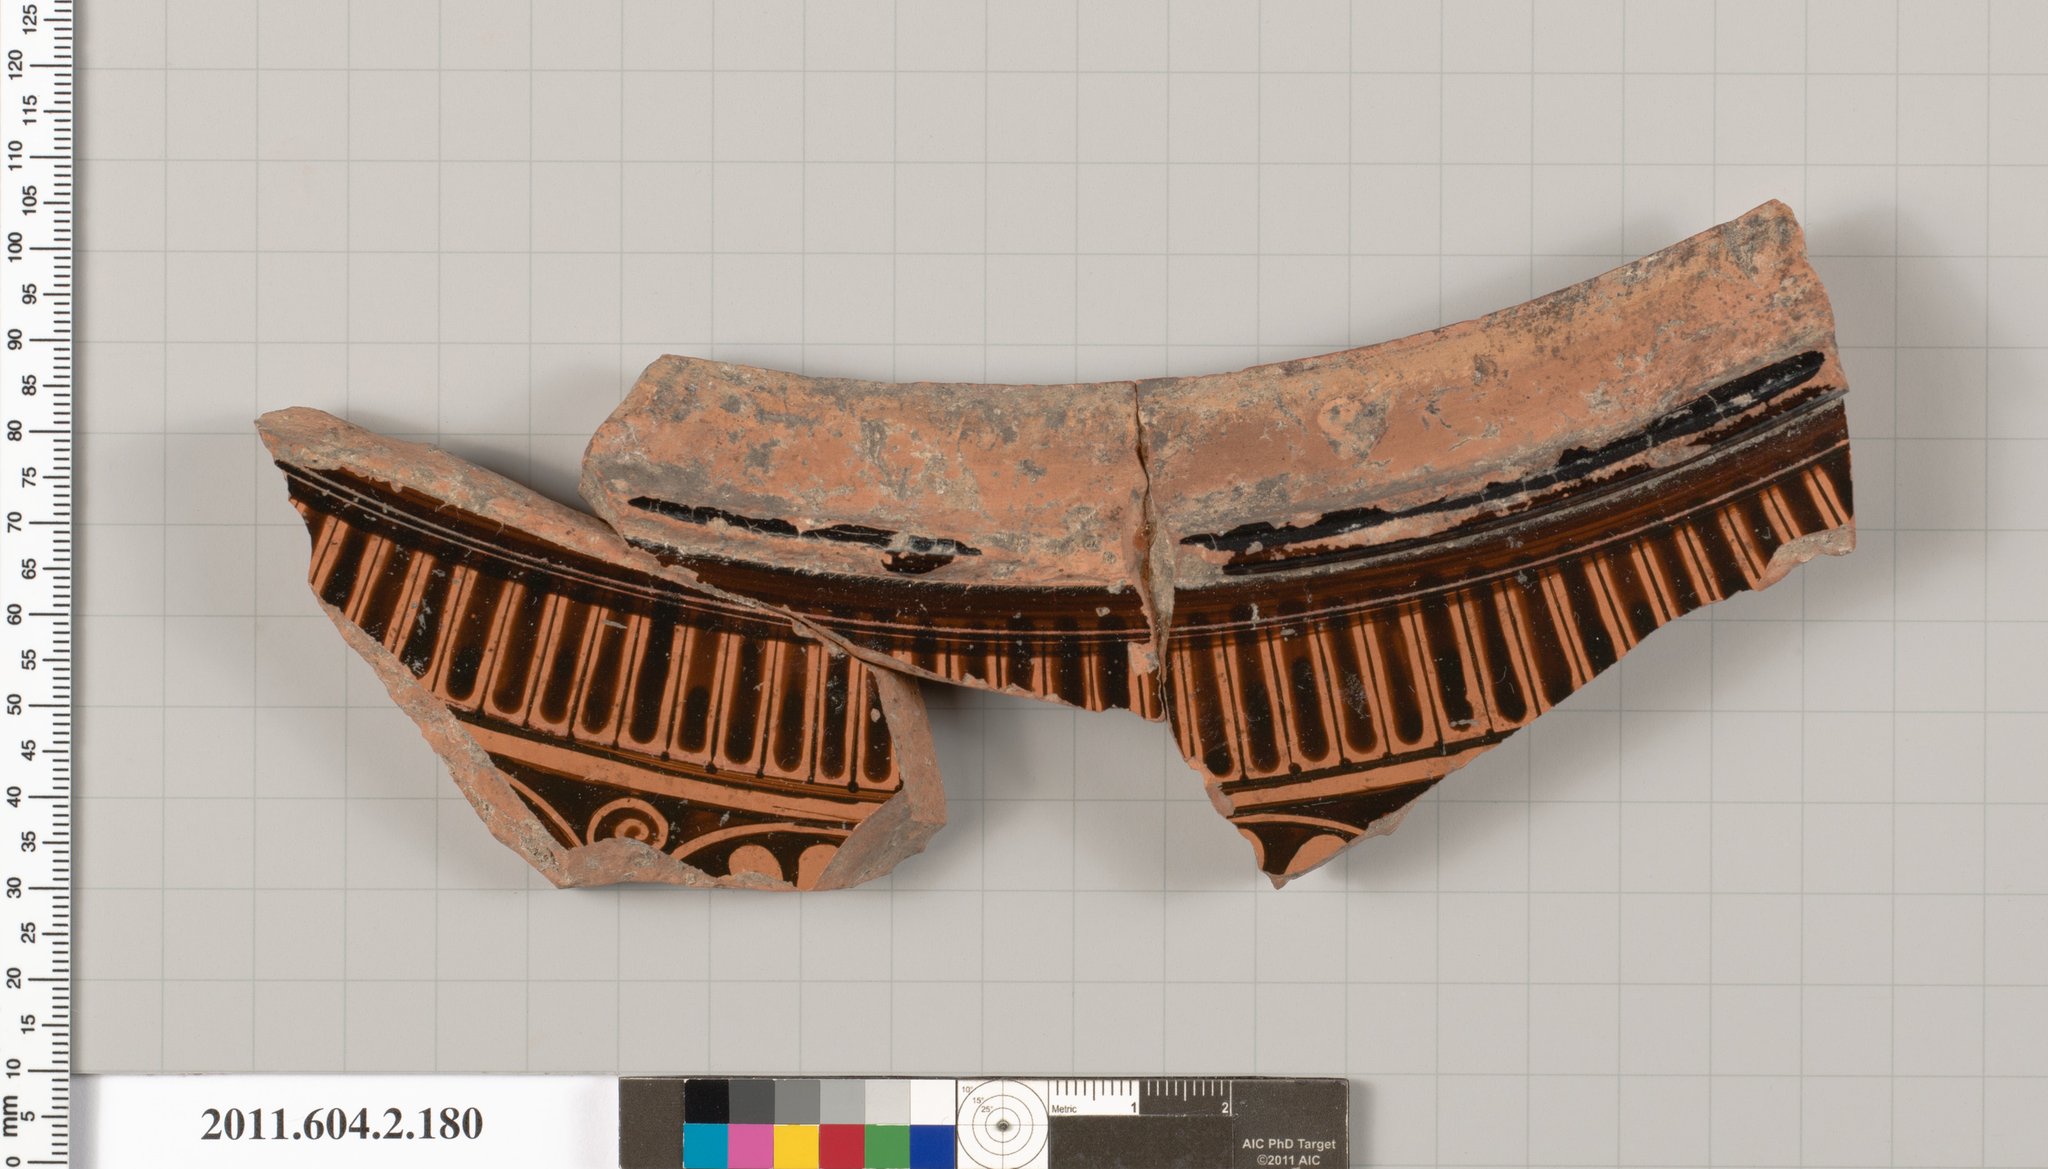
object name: stamnos fragment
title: Terracotta fragment of a stamnos (jar)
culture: greek, attic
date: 520-510 BCE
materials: terracotta